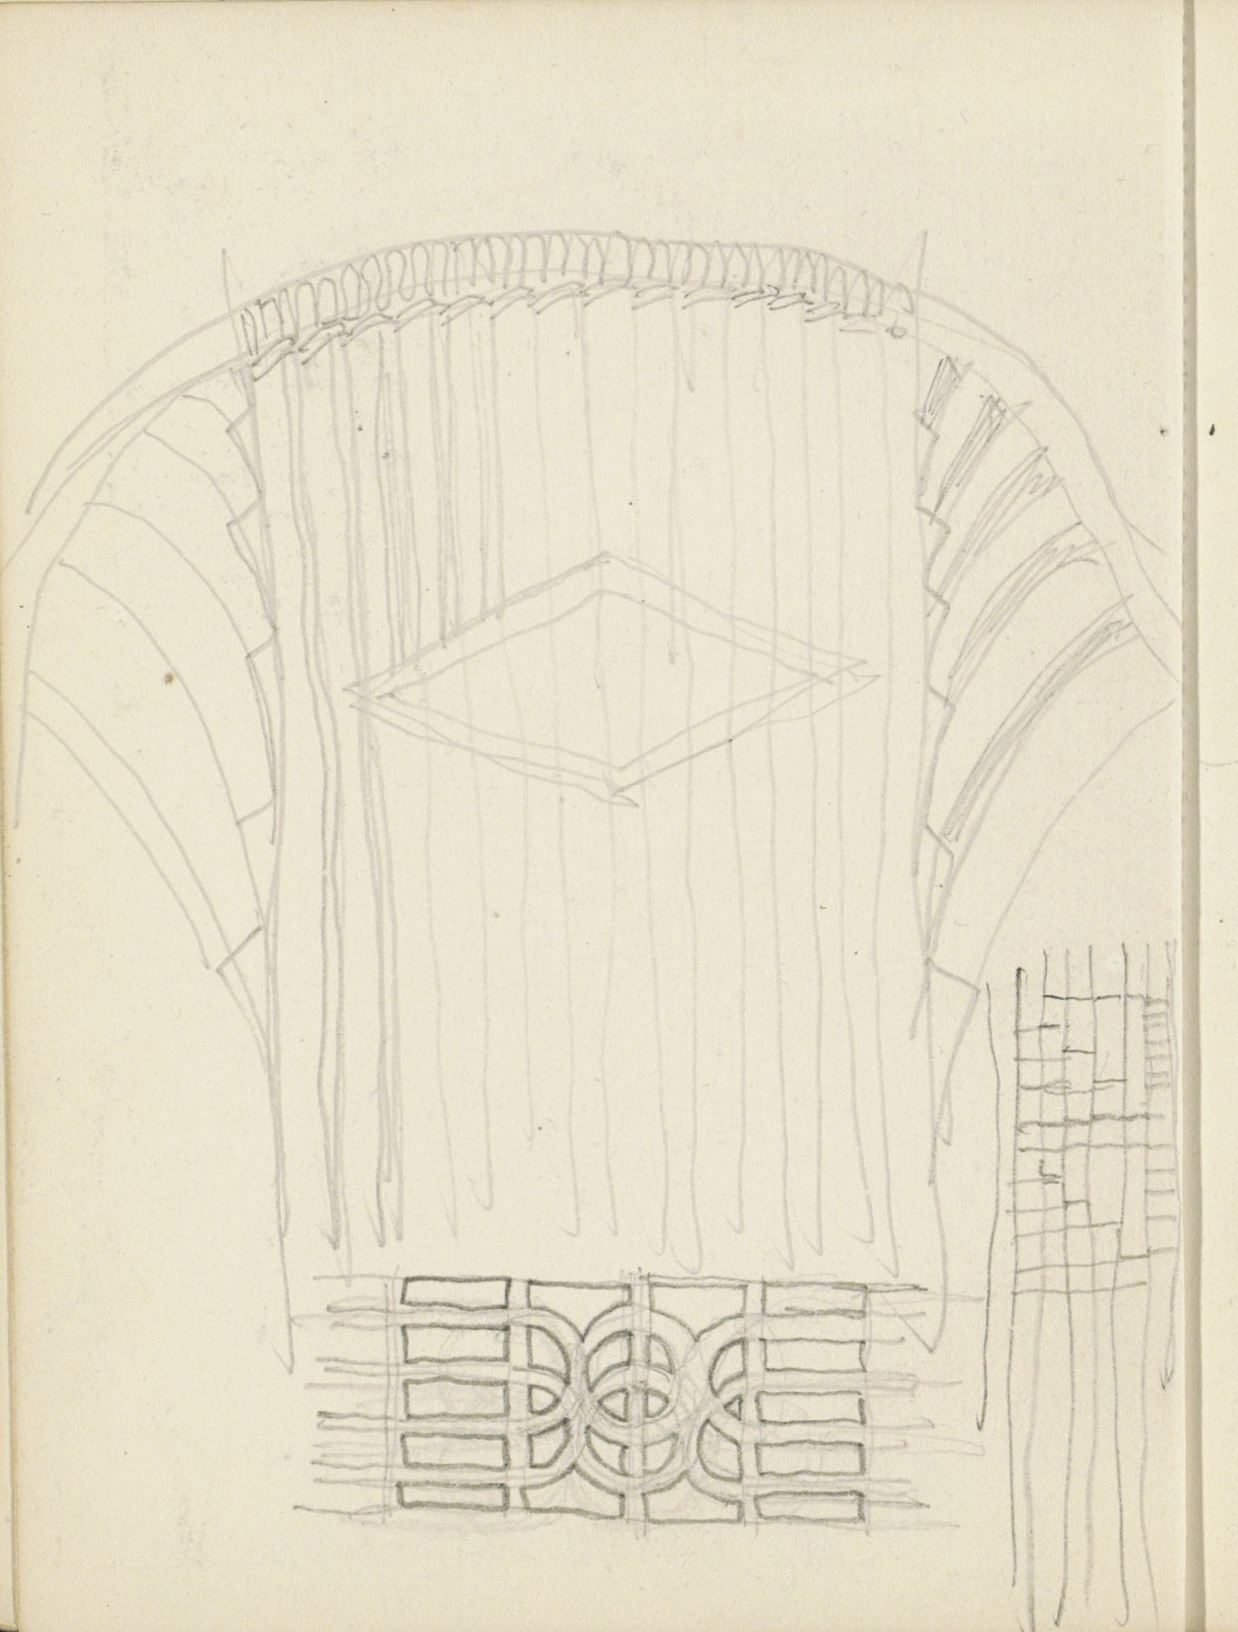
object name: sketchbook leaf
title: Decoratief patroon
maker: reijer stolk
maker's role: draughtsman, print maker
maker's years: 1896-1945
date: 1916-1945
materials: paper, pencil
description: Blad 12 verso uit een schetsboek met 60 bladen.